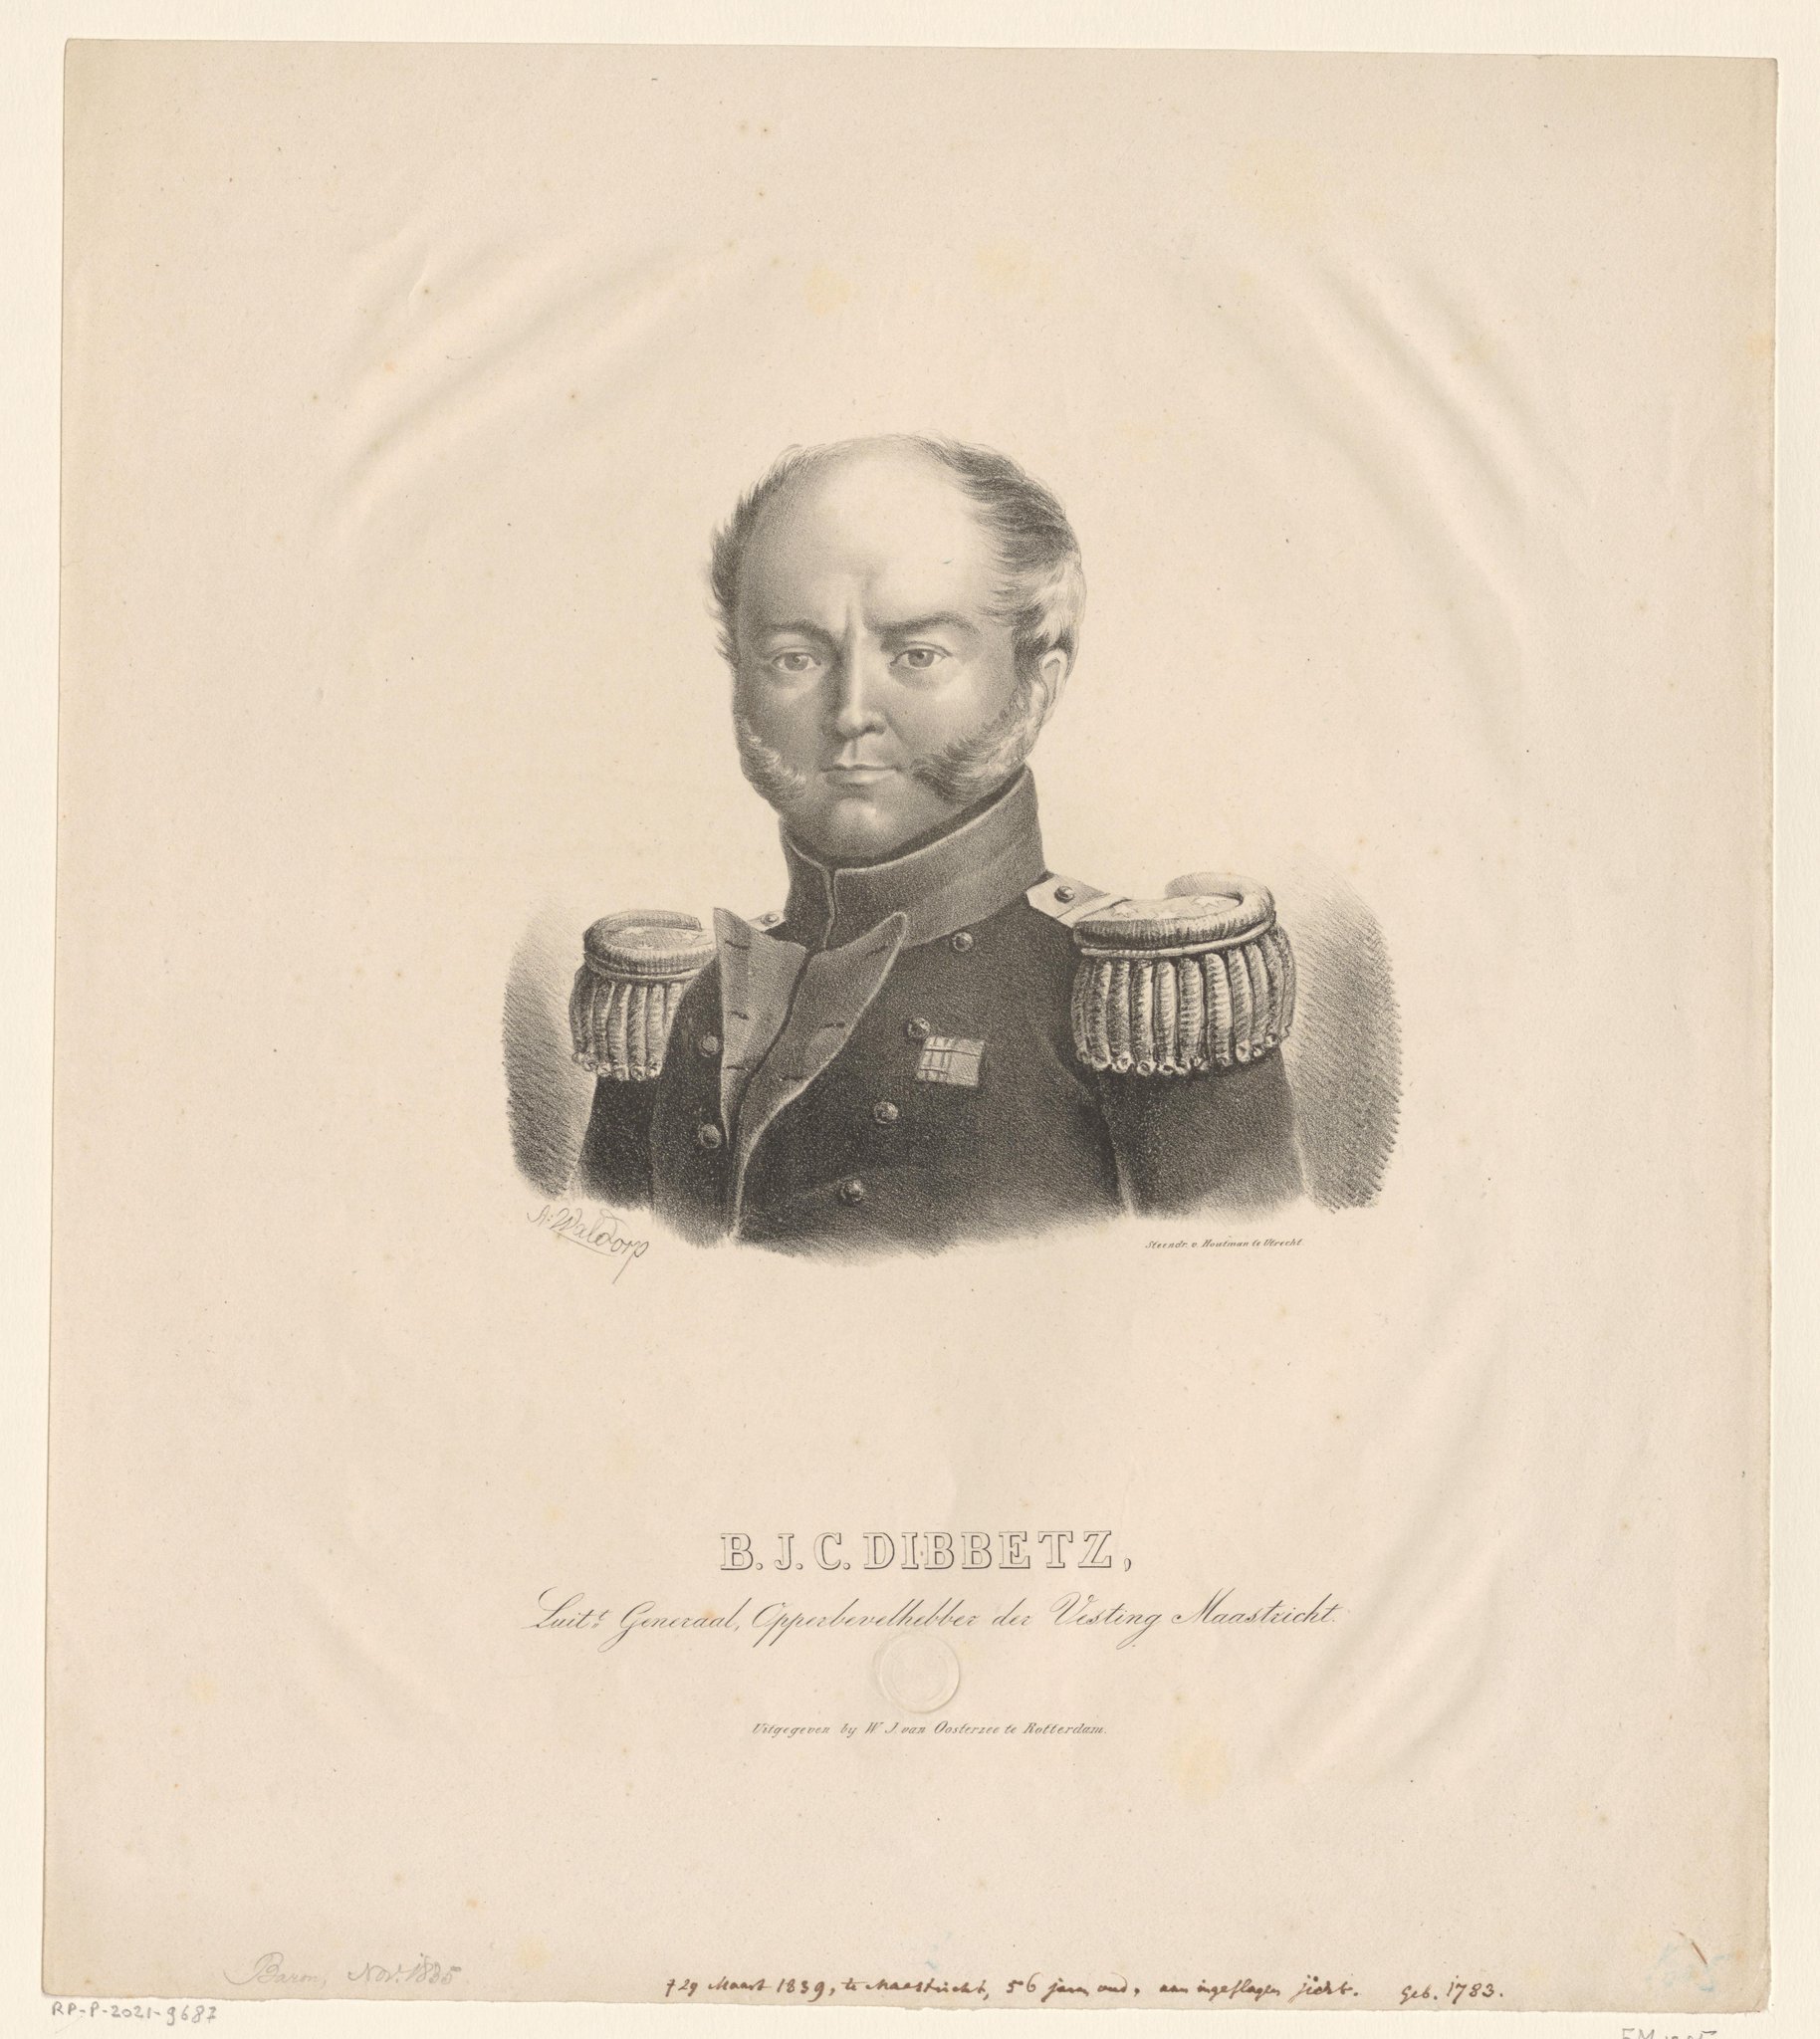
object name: print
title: B.J.C. Dibbetz, luit.t generaal, opperbevelhebber der vesting Maastricht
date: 1831-1843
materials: paper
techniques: lithograph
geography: utrecht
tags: arnhem, maastricht, commander-in-chief, general, marshal, historical persons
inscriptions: collector's mark: Lugt 2228, check stamp: ‘W[J]/ V[O]’